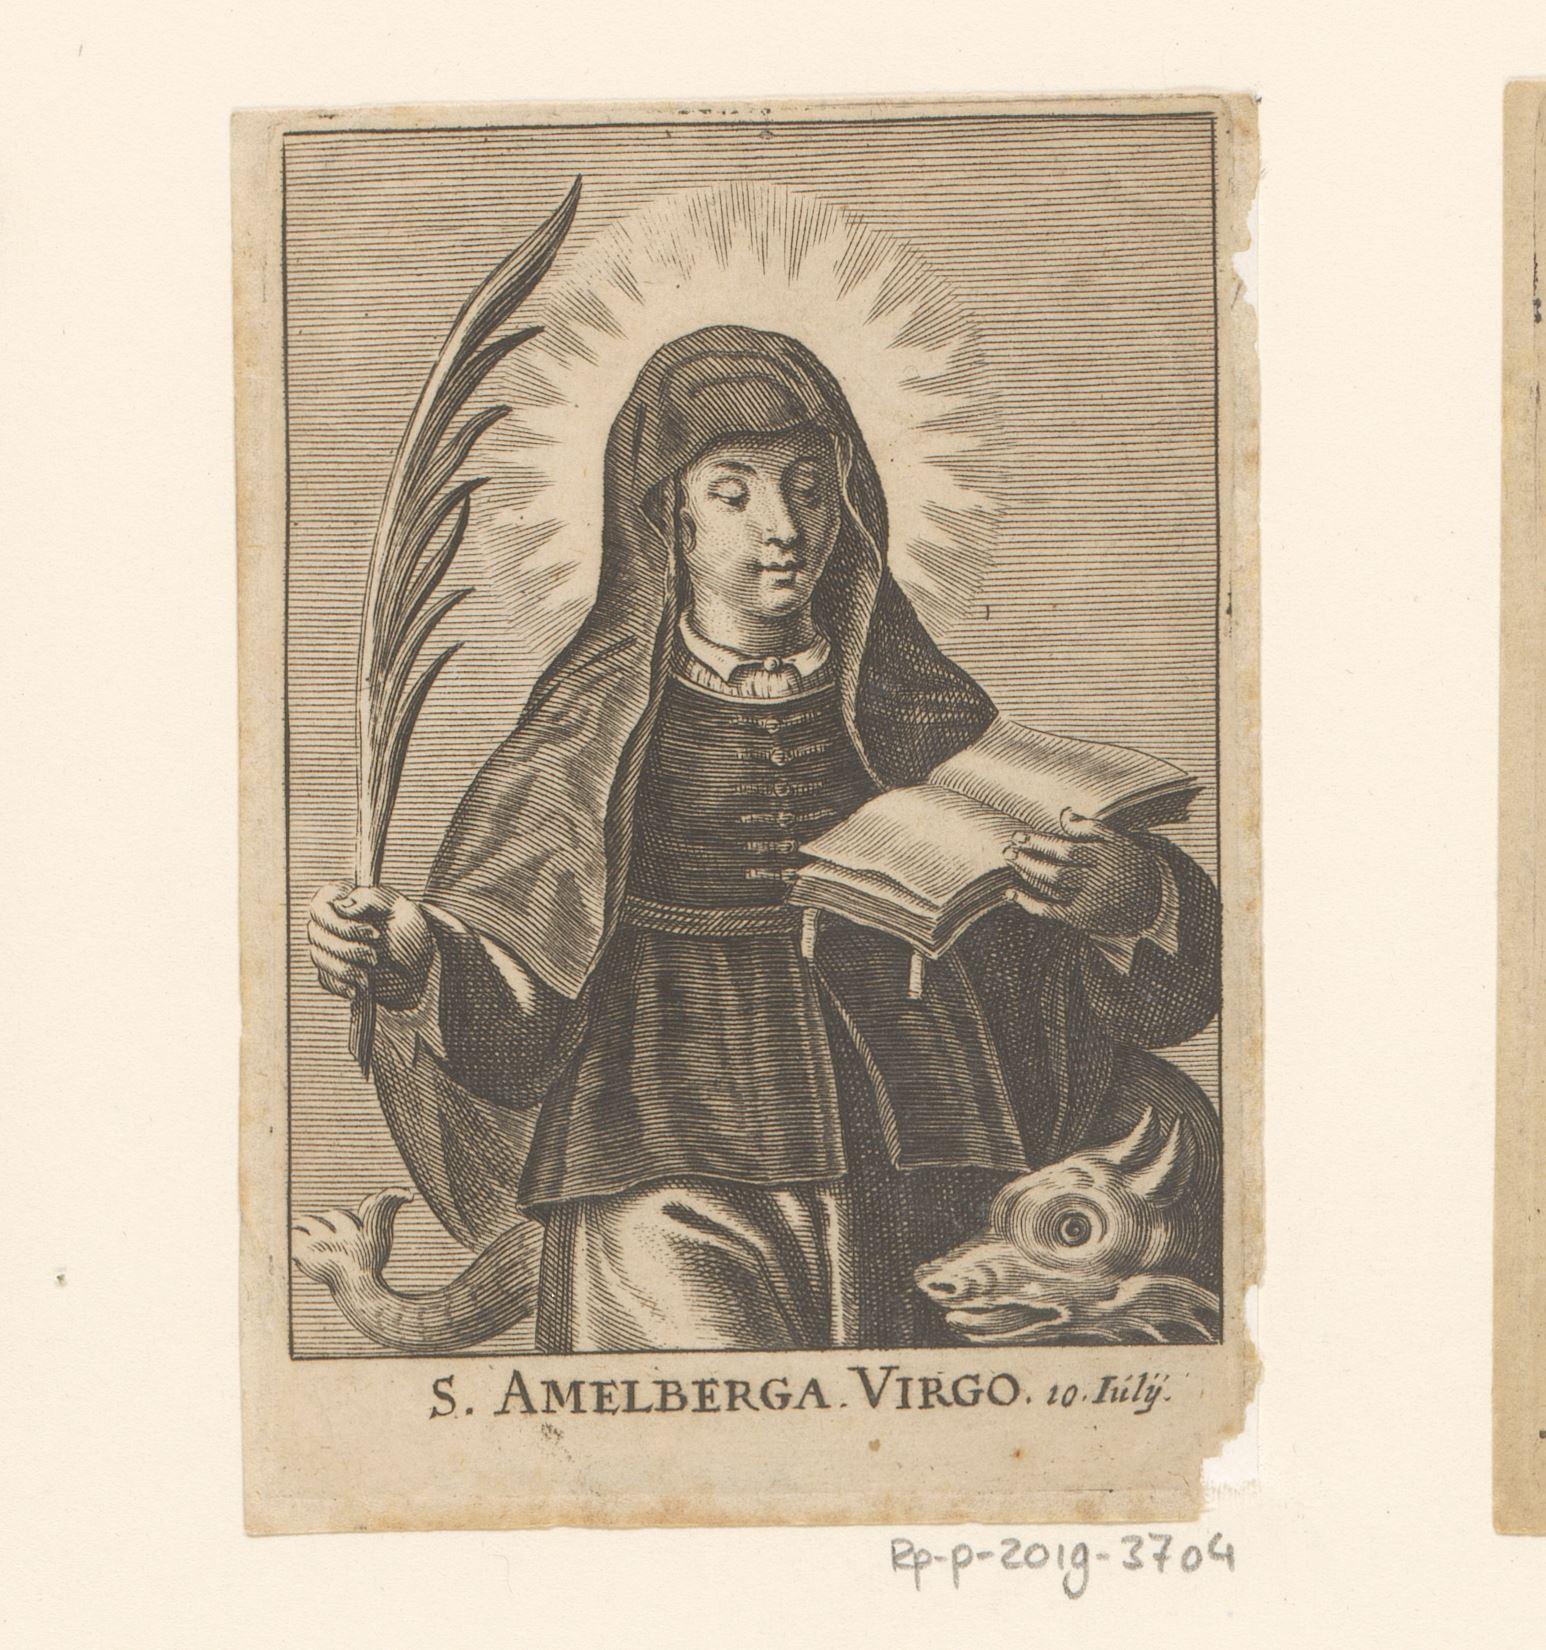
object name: print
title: Vrouwelijke heiligen en hun naamdagen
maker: Anonymous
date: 1600-1699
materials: paper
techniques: engraving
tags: female saints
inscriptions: collector's mark: Lugt 2228